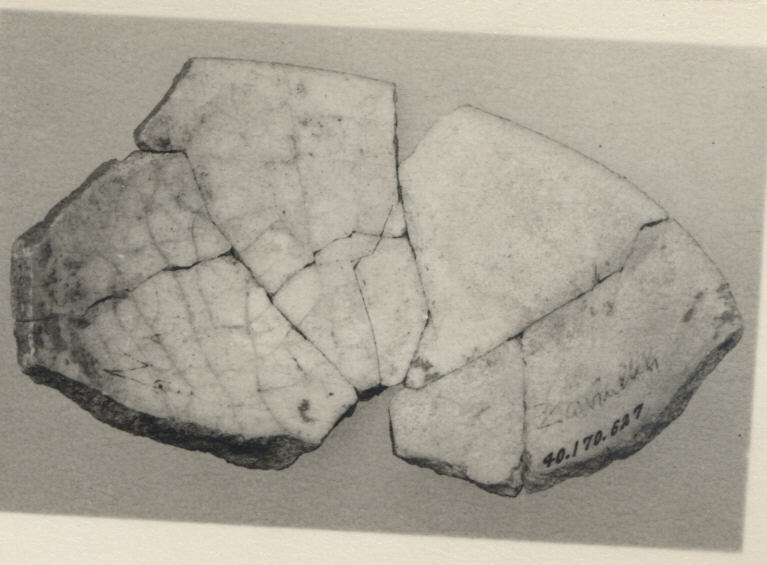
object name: fragment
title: Fragment of Bowl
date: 1501-1600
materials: earthenware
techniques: glazing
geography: iran